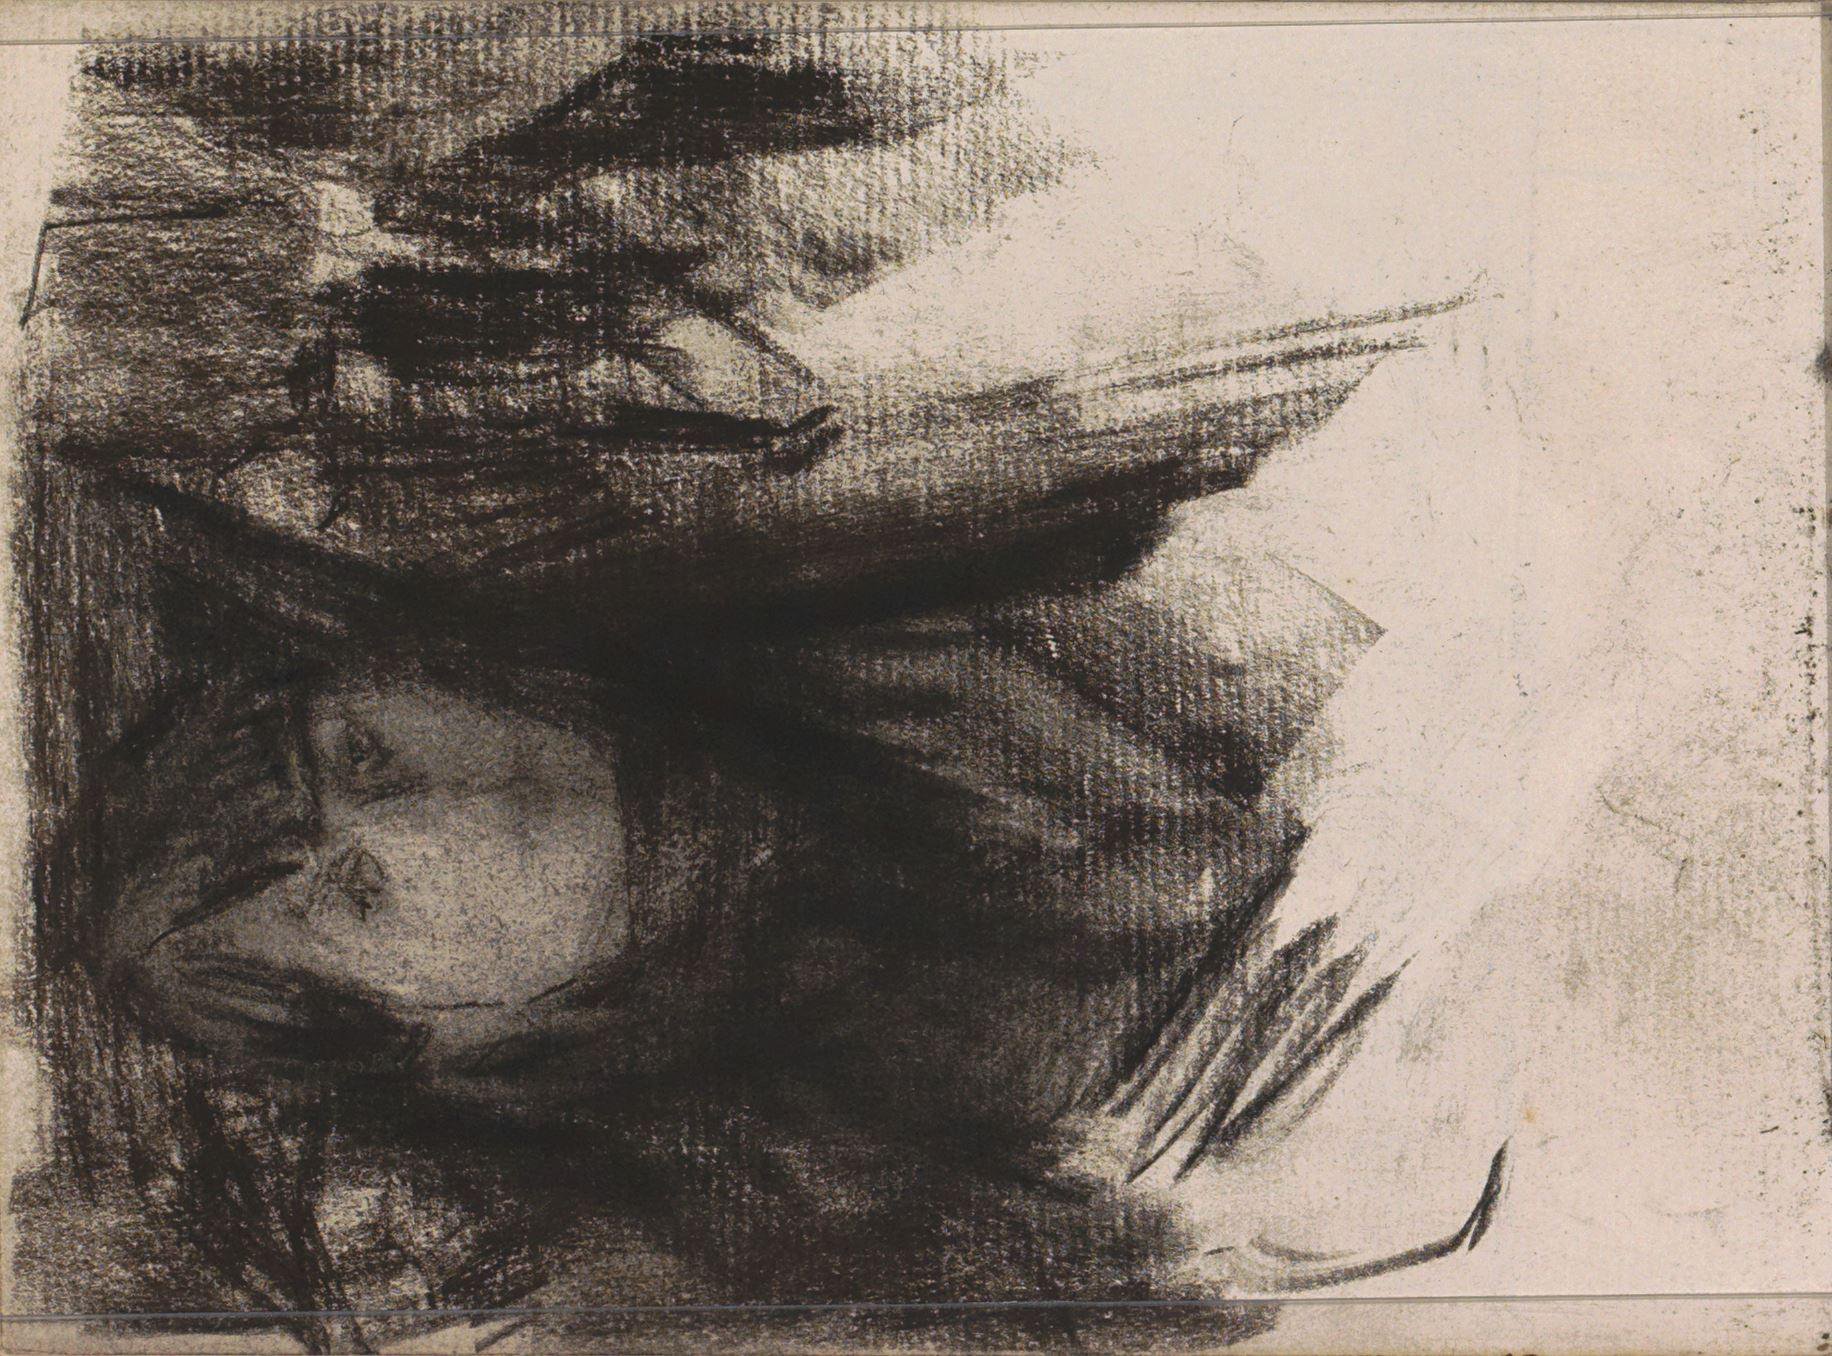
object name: sketchbook leaf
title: Vrouw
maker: isaac israels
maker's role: draughtsman, painter, print maker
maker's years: 1865-1934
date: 1886-1903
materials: chalk, paper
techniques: stumping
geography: amsterdam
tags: adult woman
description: Pagina 18 uit schetsboek XLVII met 52 pagina's.